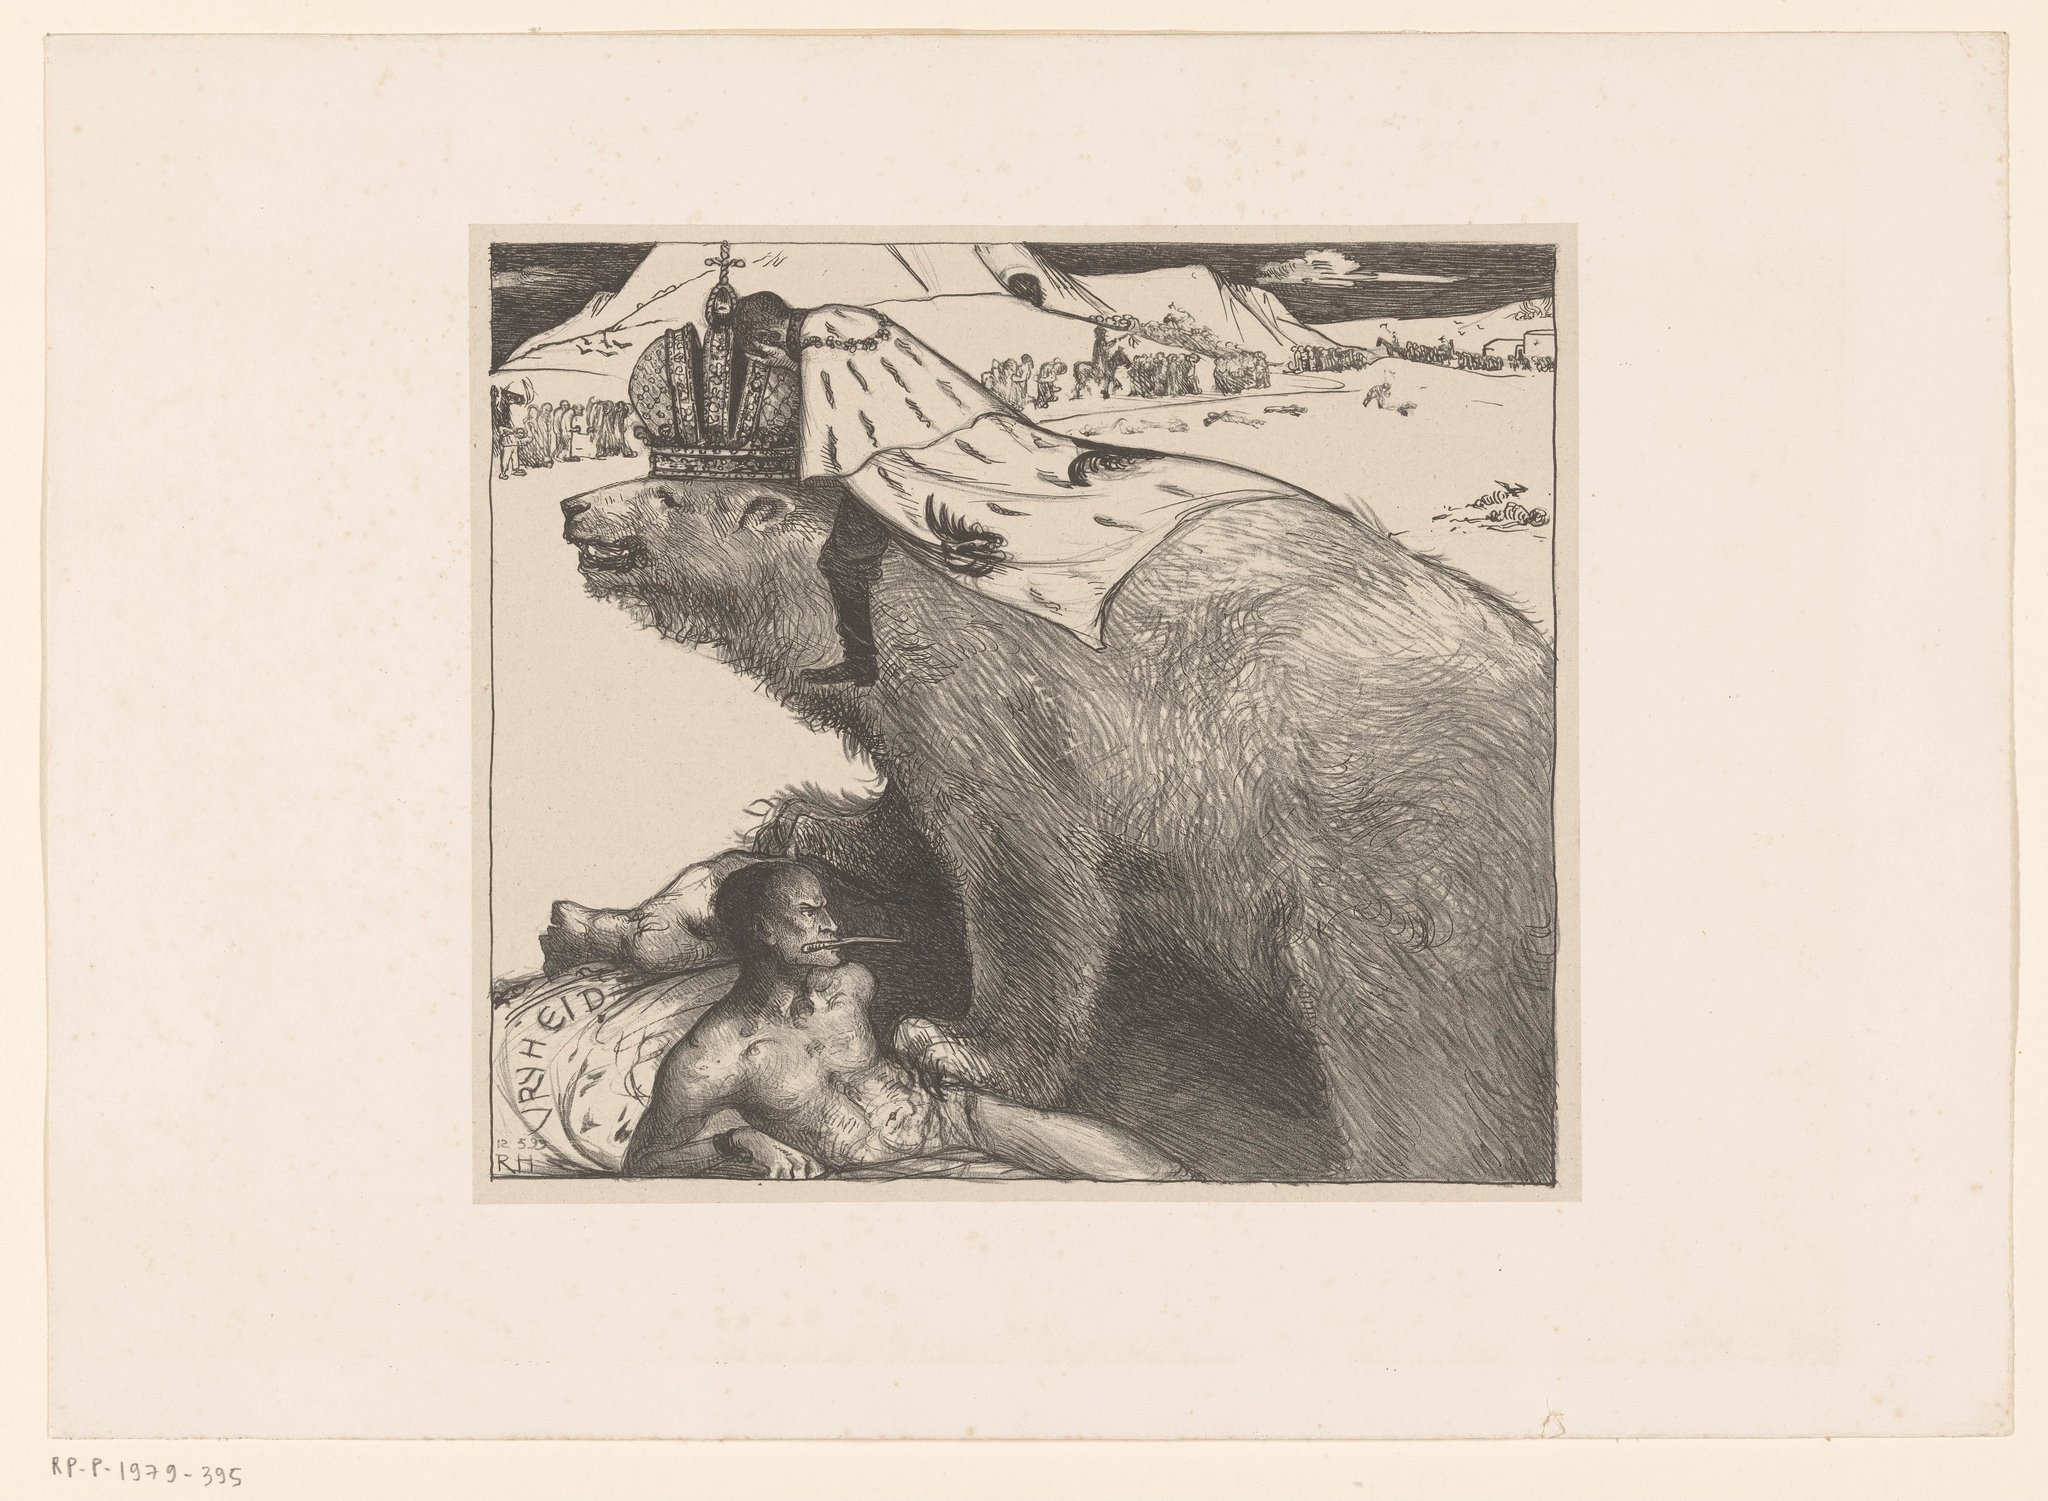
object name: cartoon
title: De Russische beer brult vrede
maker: richard nicolaüs roland holst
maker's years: 1868-1938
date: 1899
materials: paper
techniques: lithograph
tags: crown (symbol of sovereignty), deportation, beasts of prey, predatory animals: bear, emperor, freedom, liberty; 'libertà' (ripa), symbols of particular nations, states, districts, etc., russia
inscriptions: collector's mark: Lugt 2228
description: Prent gebruikt voor: 'De Plaat', het bijvoegsel van 'De Sociaaldemokraat, orgaan der Sociaaldemokratische Arbeiderspartij in Nederland'. Bij de prent verscheen een tekst van Henriëtte Roland Holst-van der Schalk met de titel 'De Russische beer brult vrede' waarin wordt ingegaan op de inhoud van de prent: 'Hoe verhoudt gij u, Russische beer, tegen Recht, Vrijheid en Broederschap, die wegbereiders van Vrede? Hoe staat het daarmee bij u, klein nietigheidje, angstig berijder van het monster Autokratie met zijn krachtigen klauw en listige oogjes, bij u, Tzar van Rusland?'